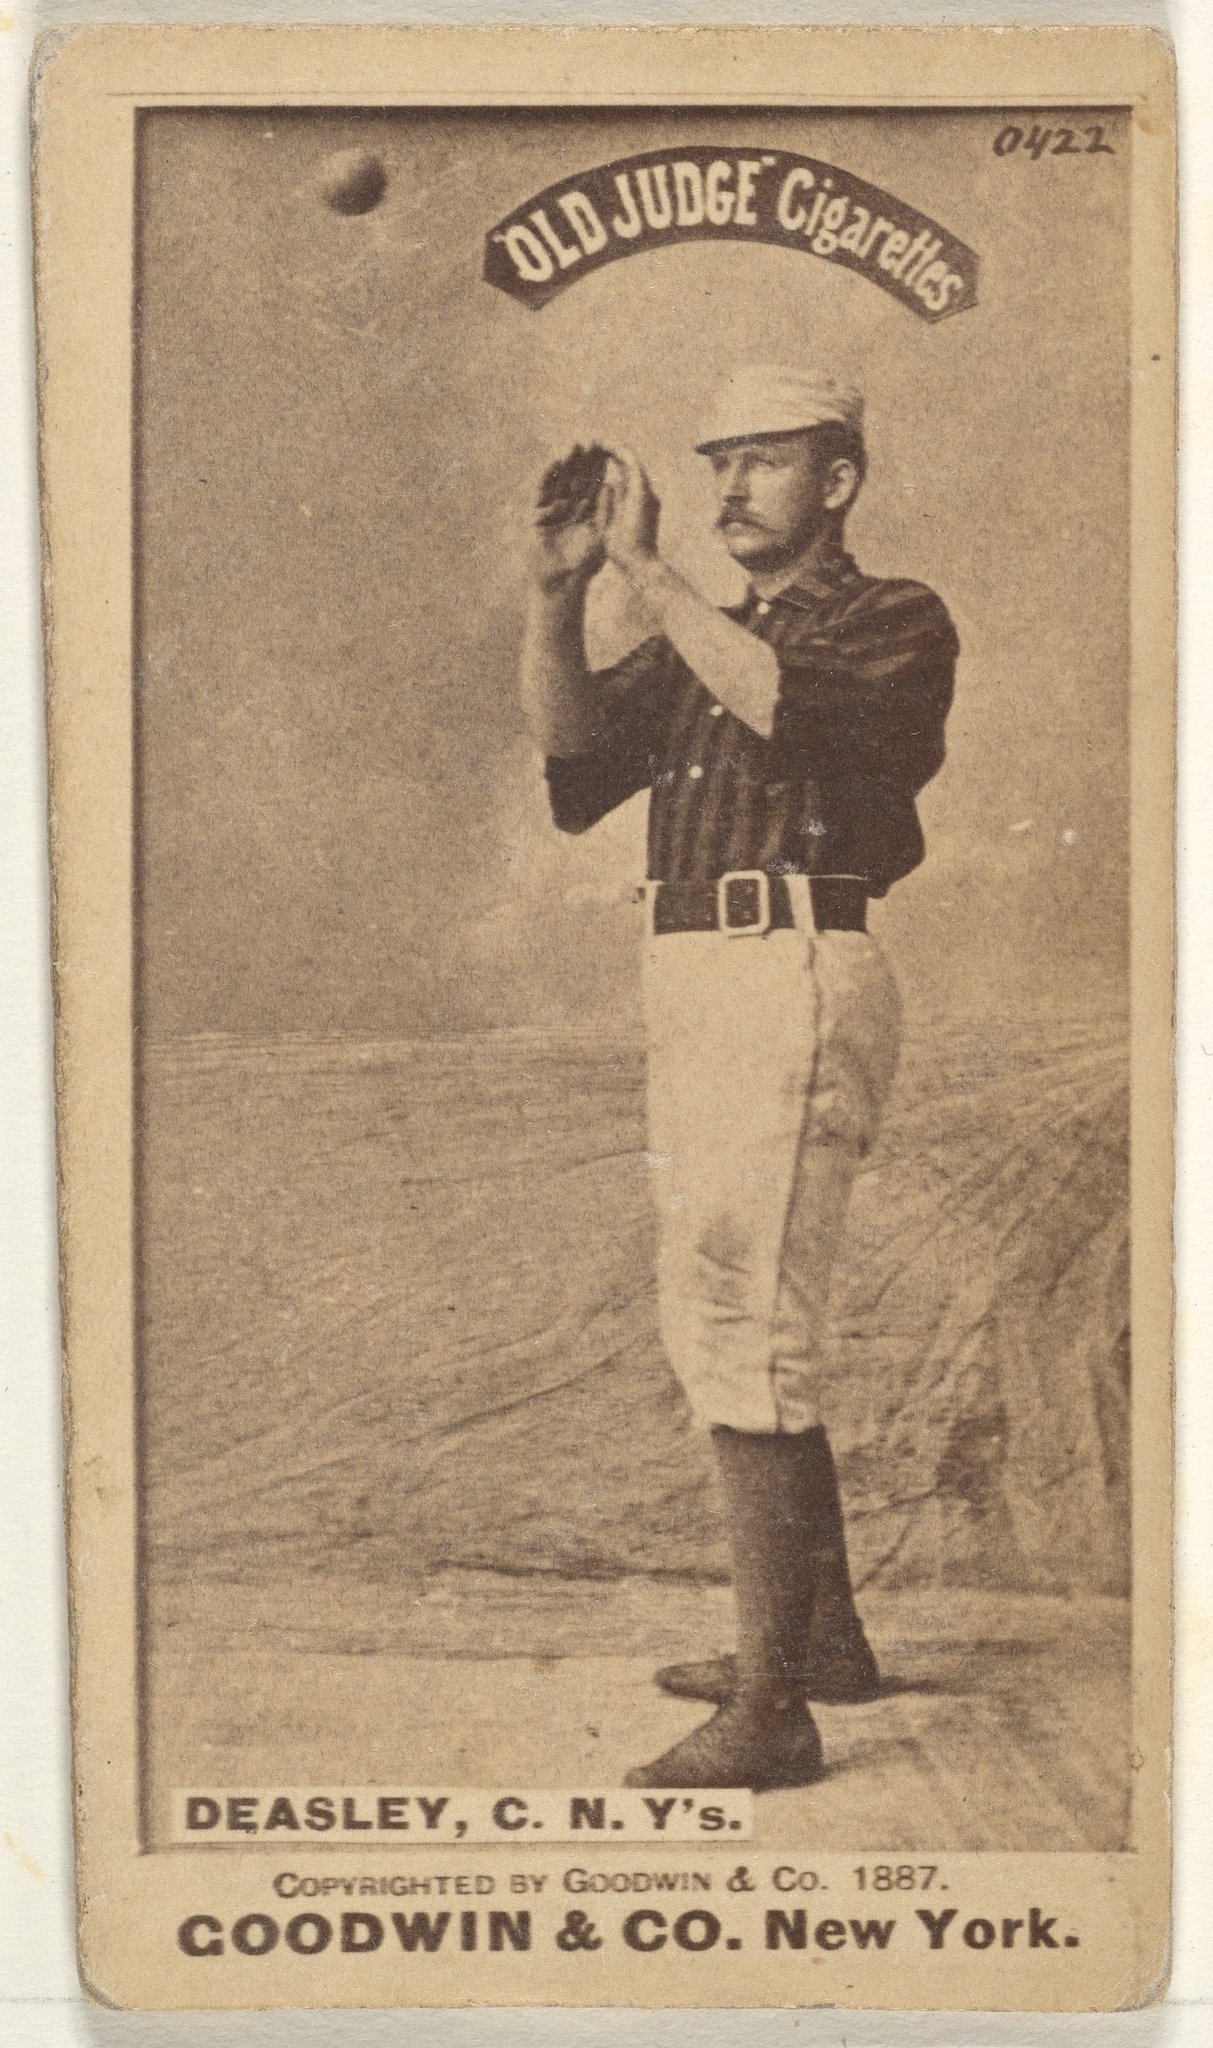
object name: baseball card, photograph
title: Thomas H. "Pat" Deasley, Catcher, New York, from the Old Judge series (N172) for Old Judge Cigarettes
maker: goodwin & company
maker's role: publisher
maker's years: 1850-1950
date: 1887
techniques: albumen silver print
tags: men,portraits,baseball,athletes